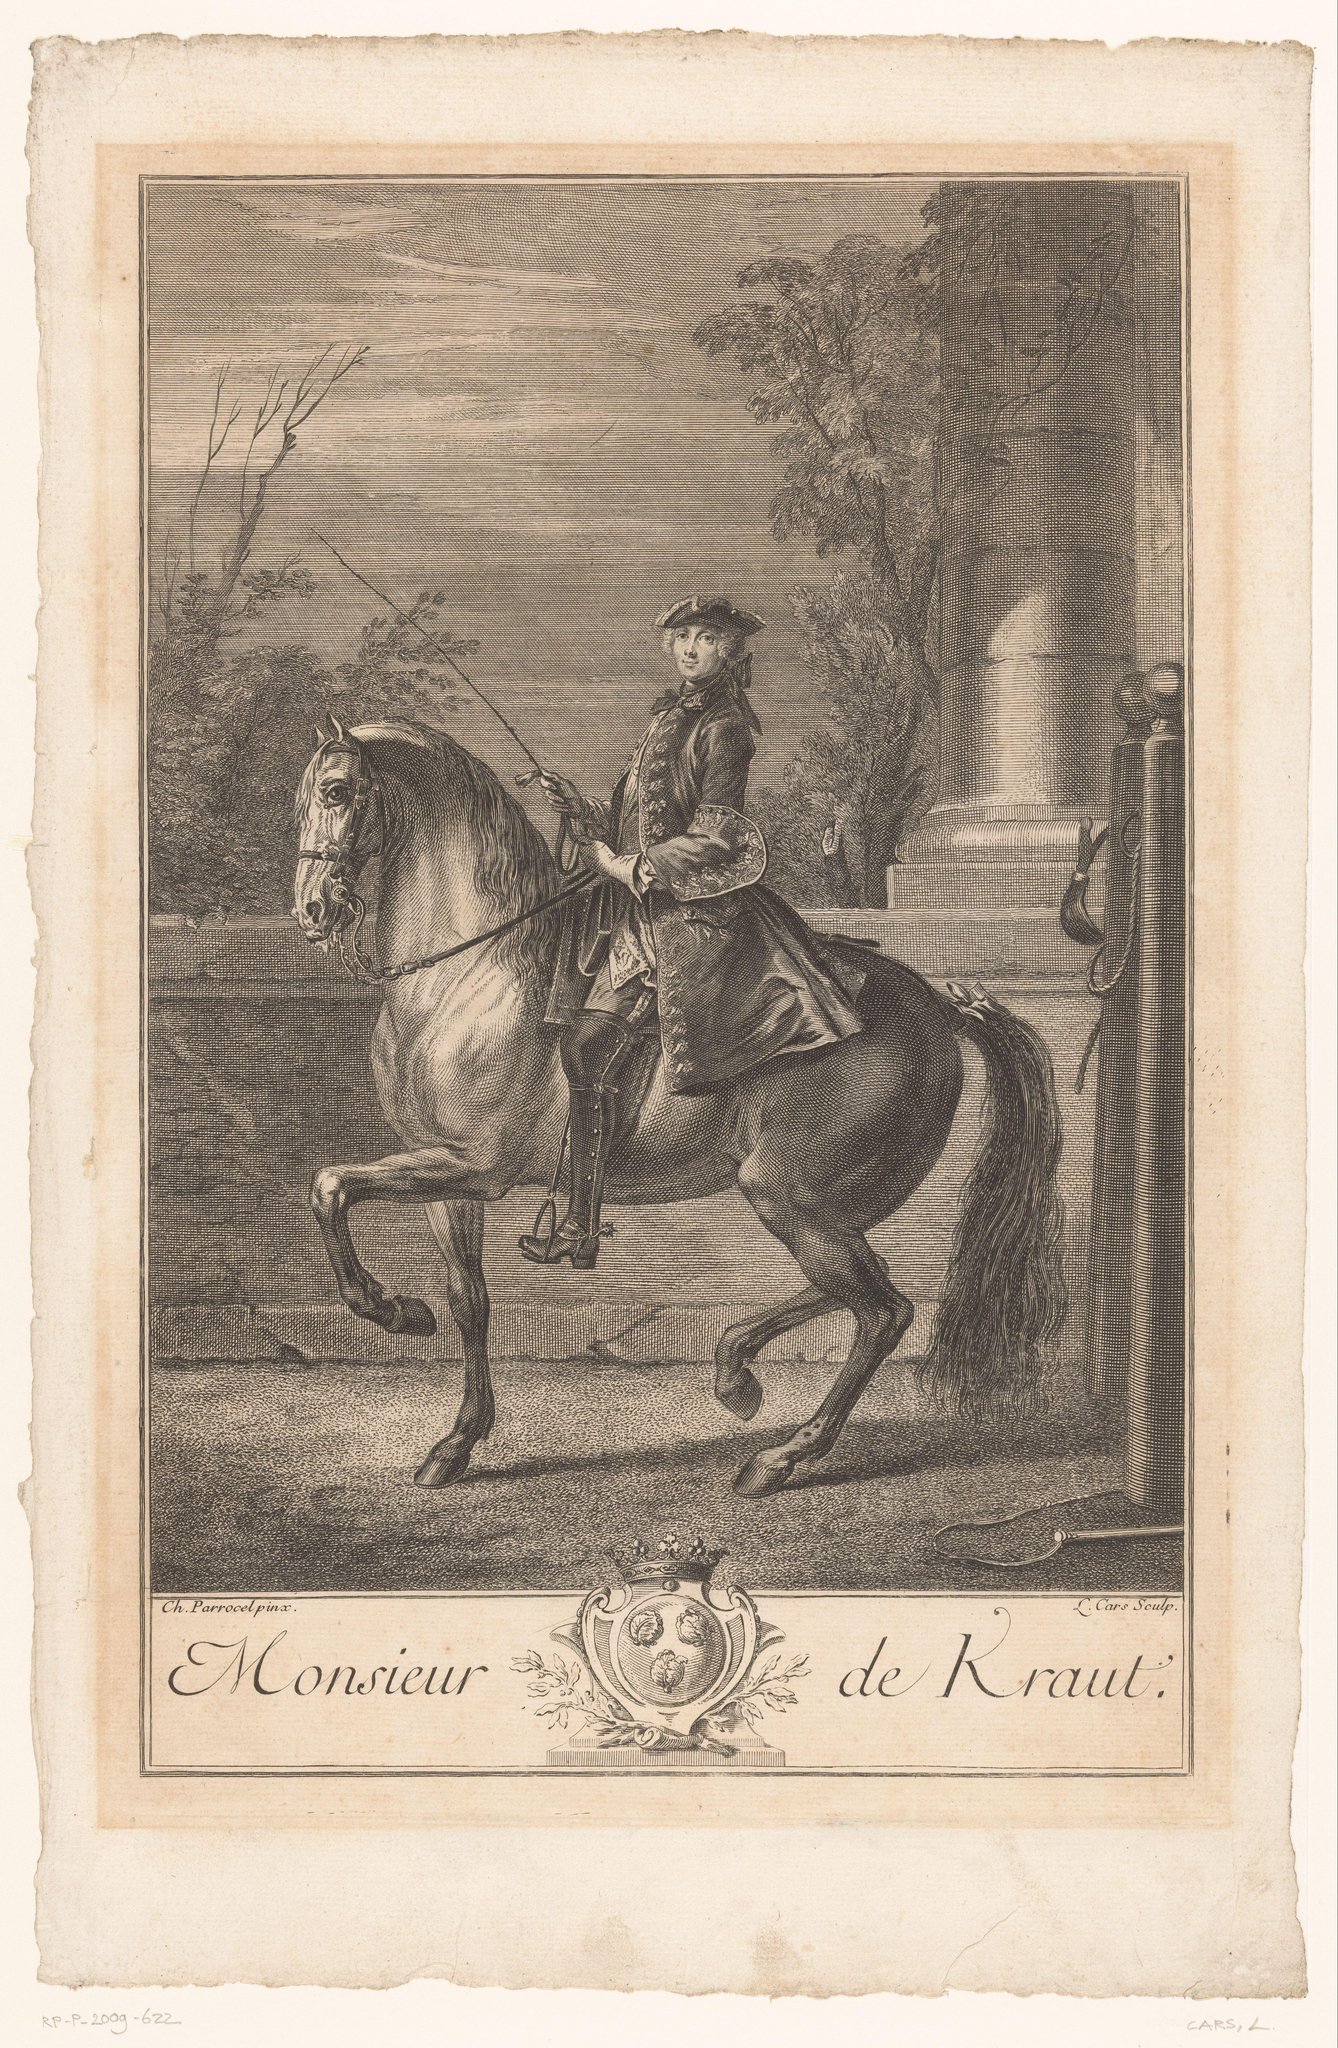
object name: book illustration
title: Monsieur de Kraut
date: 1733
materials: paper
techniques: engraving, etching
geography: france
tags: historical persons, high-school riding, armorial bearing, heraldry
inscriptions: collector's mark: Lugt 2228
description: Portret van een man te paard, met een zweep in de hand, de piaffe uitvoerend. Op de achtergrond een muur waarop rechts een zuil. Onder de afbeelding de titel en een gekroond familiewapen met drie kolen tussen twee bladertakken.